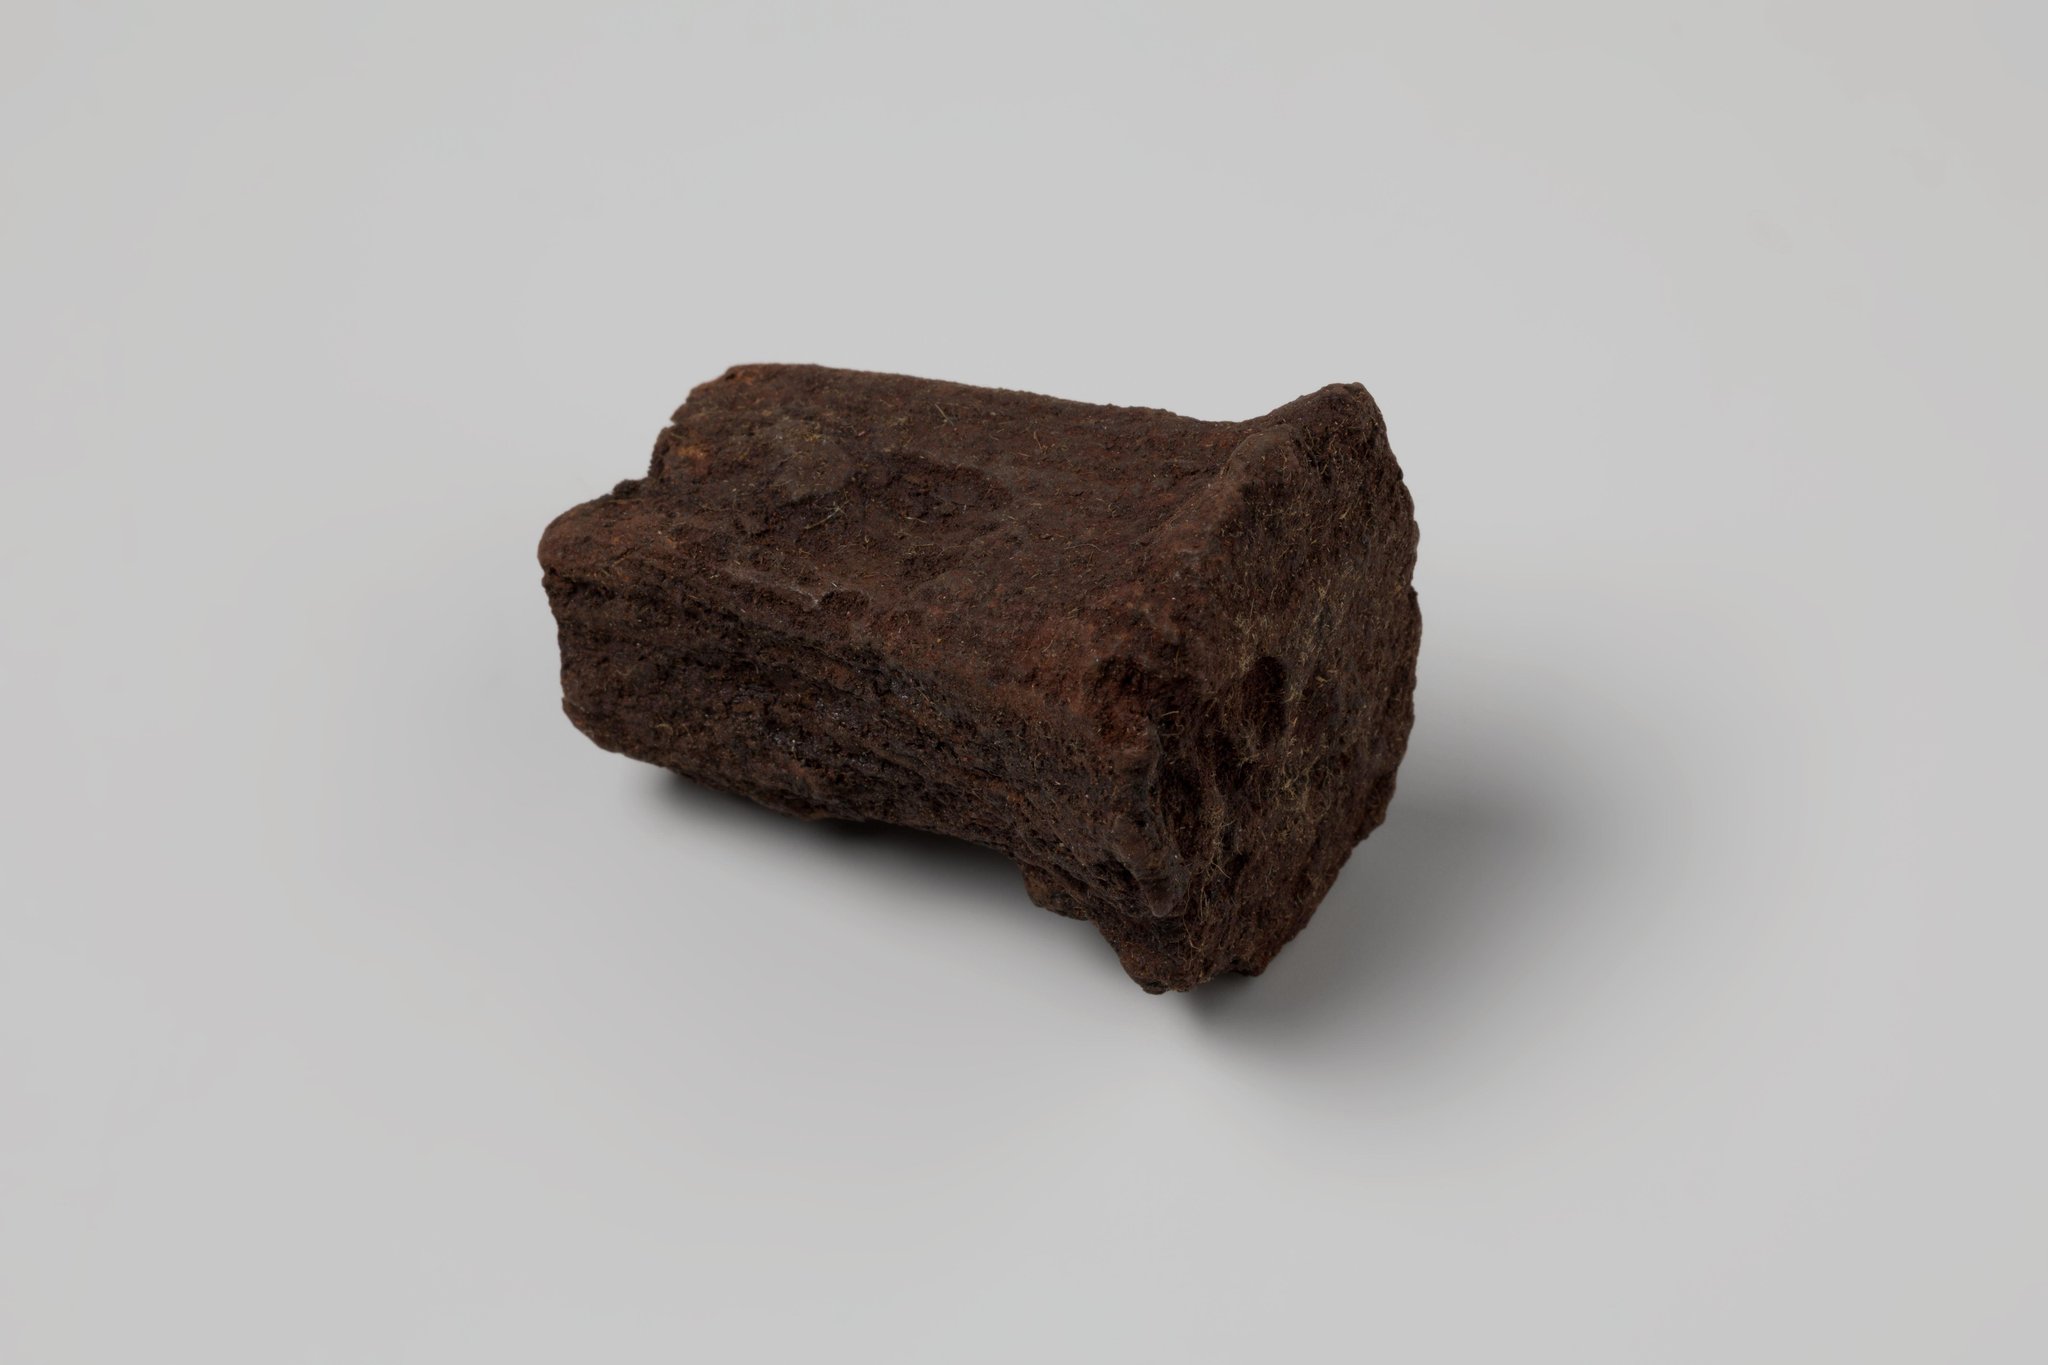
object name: hammer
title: Fragment van een hamerkop uit het wrak van de Oost-Indiëvaarder Hollandia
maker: Anonymous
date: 1700-1743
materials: iron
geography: netherlands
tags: verenigde oostindische compagnie, hollandia (schip), annet